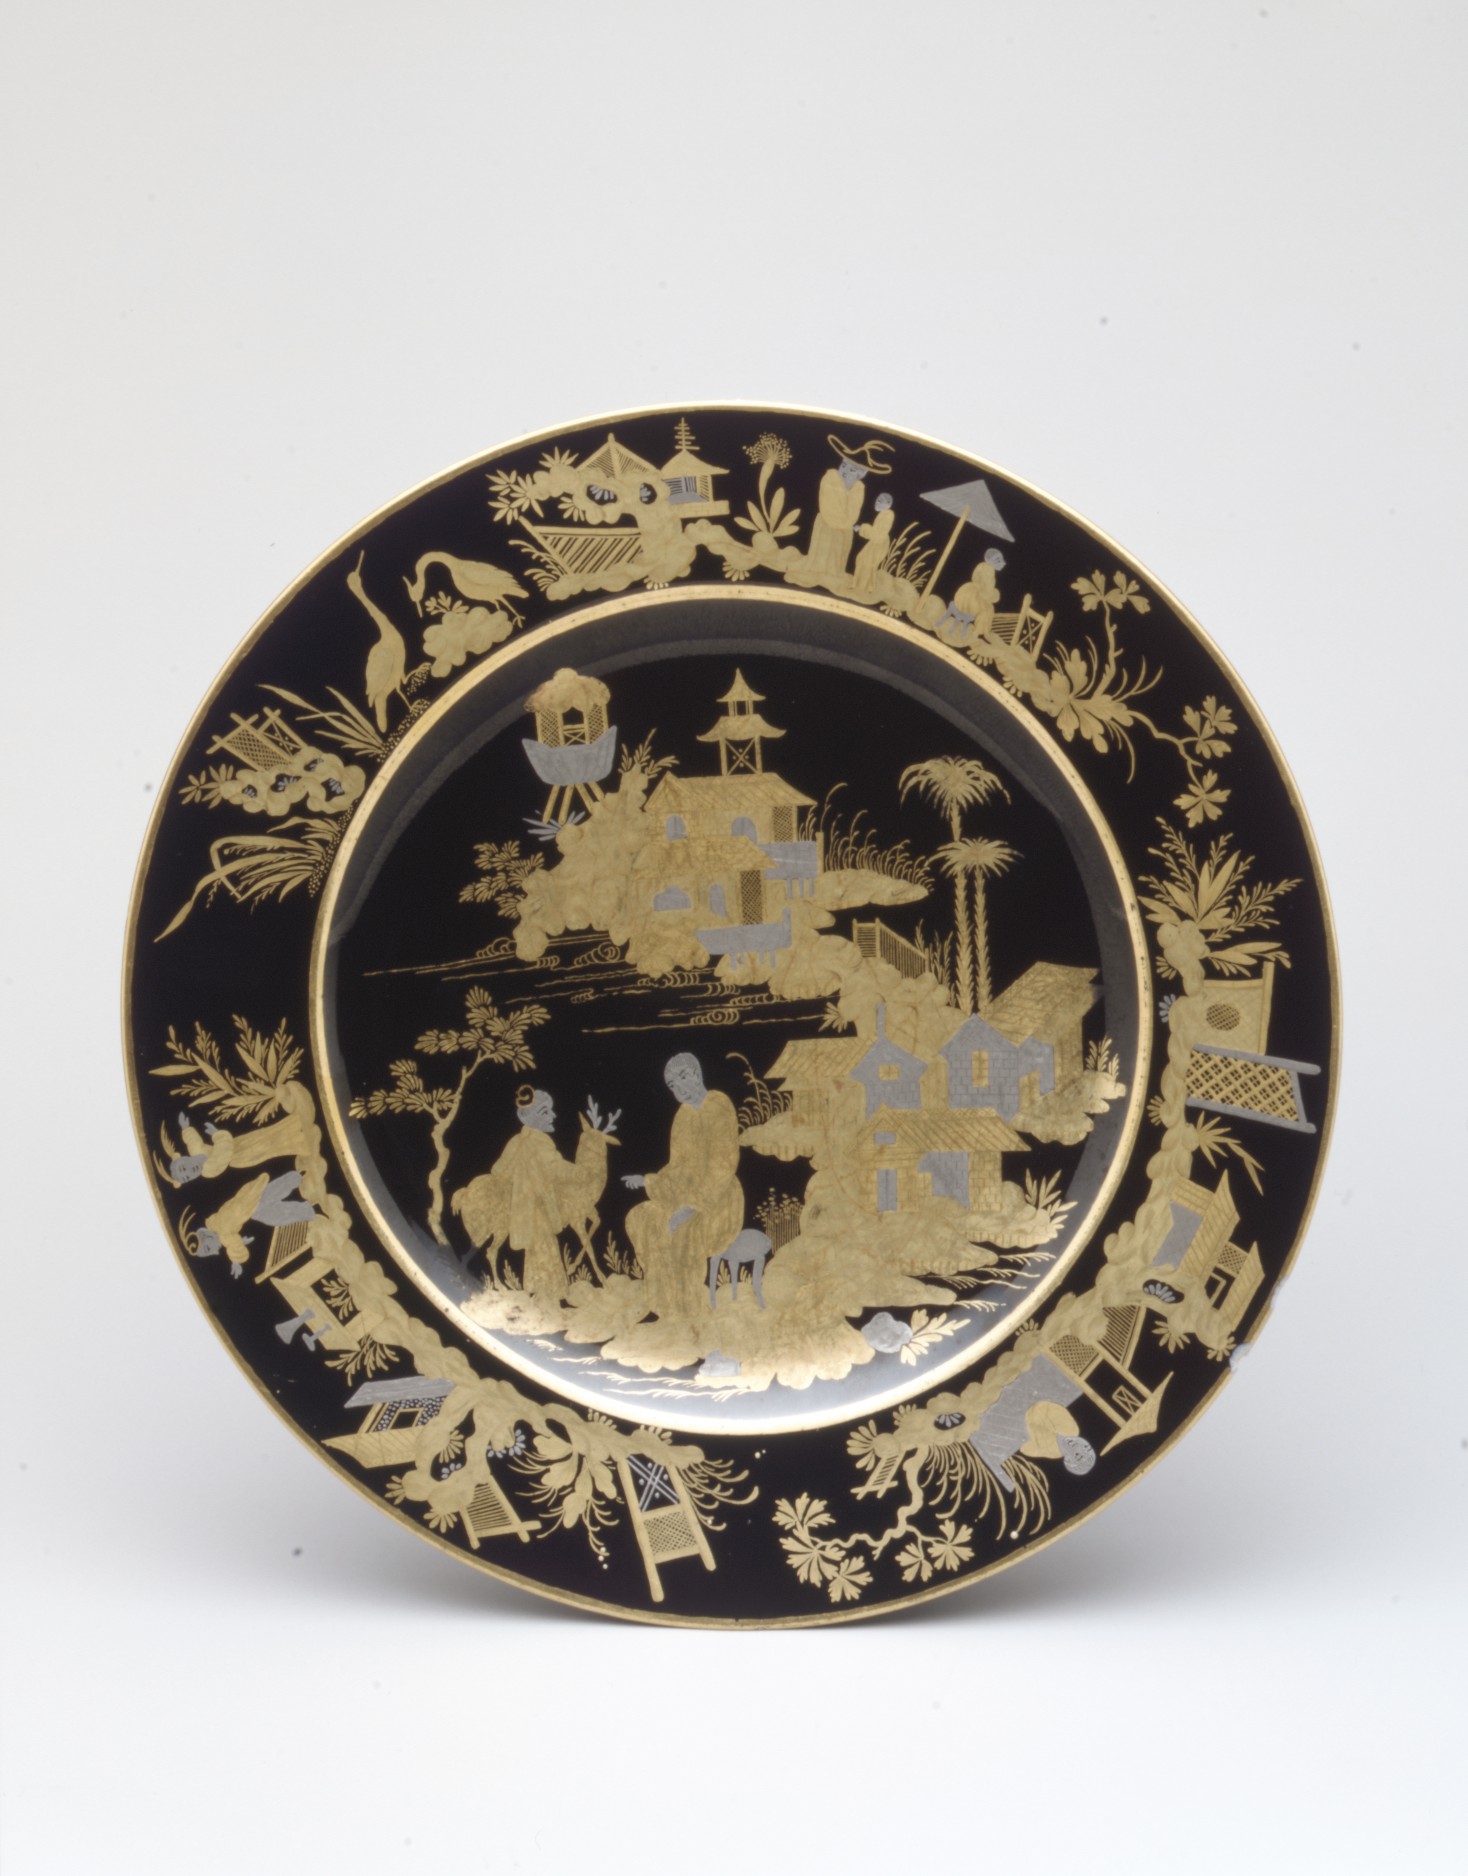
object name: plate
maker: sèvres manufactory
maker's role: manufactory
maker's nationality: french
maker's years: 1740-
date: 1791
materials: hard paste porcelain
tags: chinoiserie,buildings,men